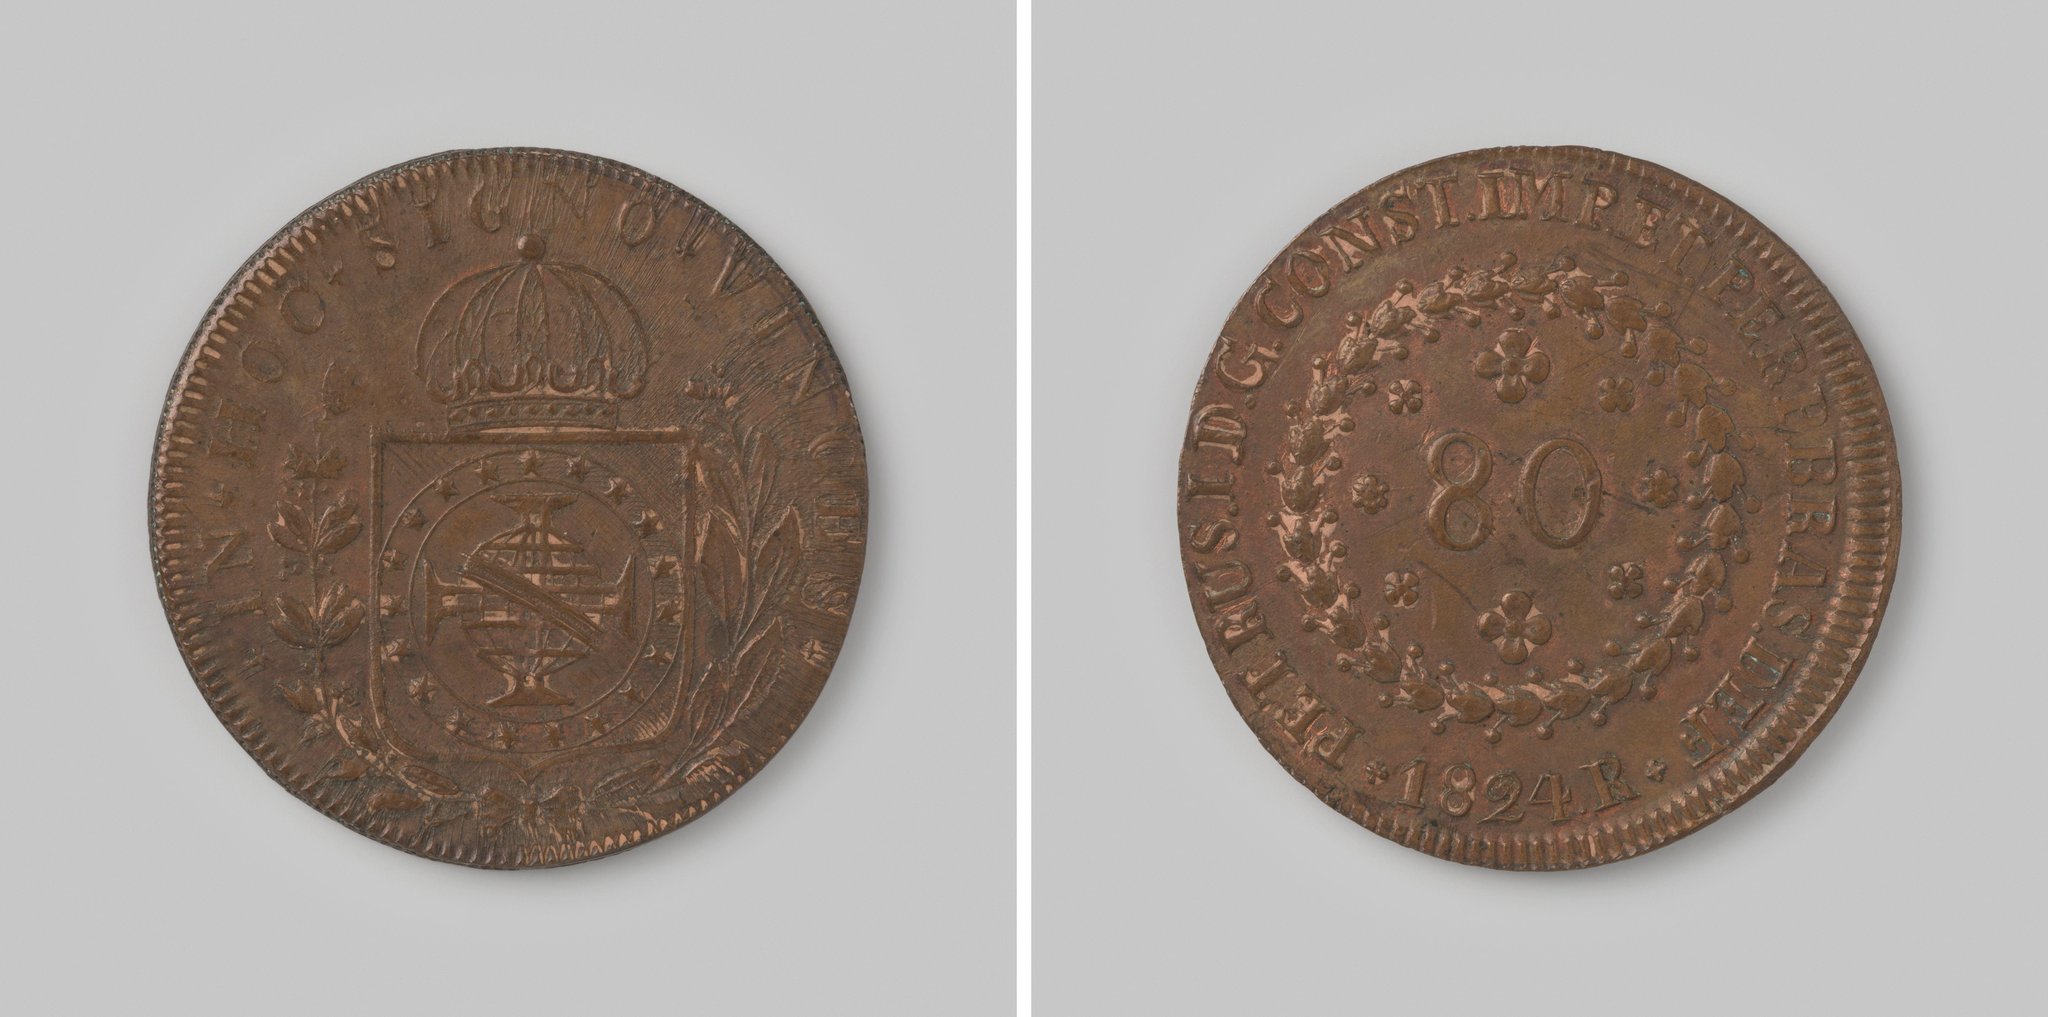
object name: coin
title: Brazilië, D. Pedro I, 80 reis,1824 R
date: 1824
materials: copper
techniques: striking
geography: rio de janeiro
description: Koperen munt. Voorzijde: tussen twee samengebonden takken gekroond wapenschild van Brazilië. Keerzijde: binnen cirkel van bloemen waarde-aanduiding: 80. In omschrift onderaan jaartal met rechts daarvan letter R [=Rio]. Kartelrand in gleuf.